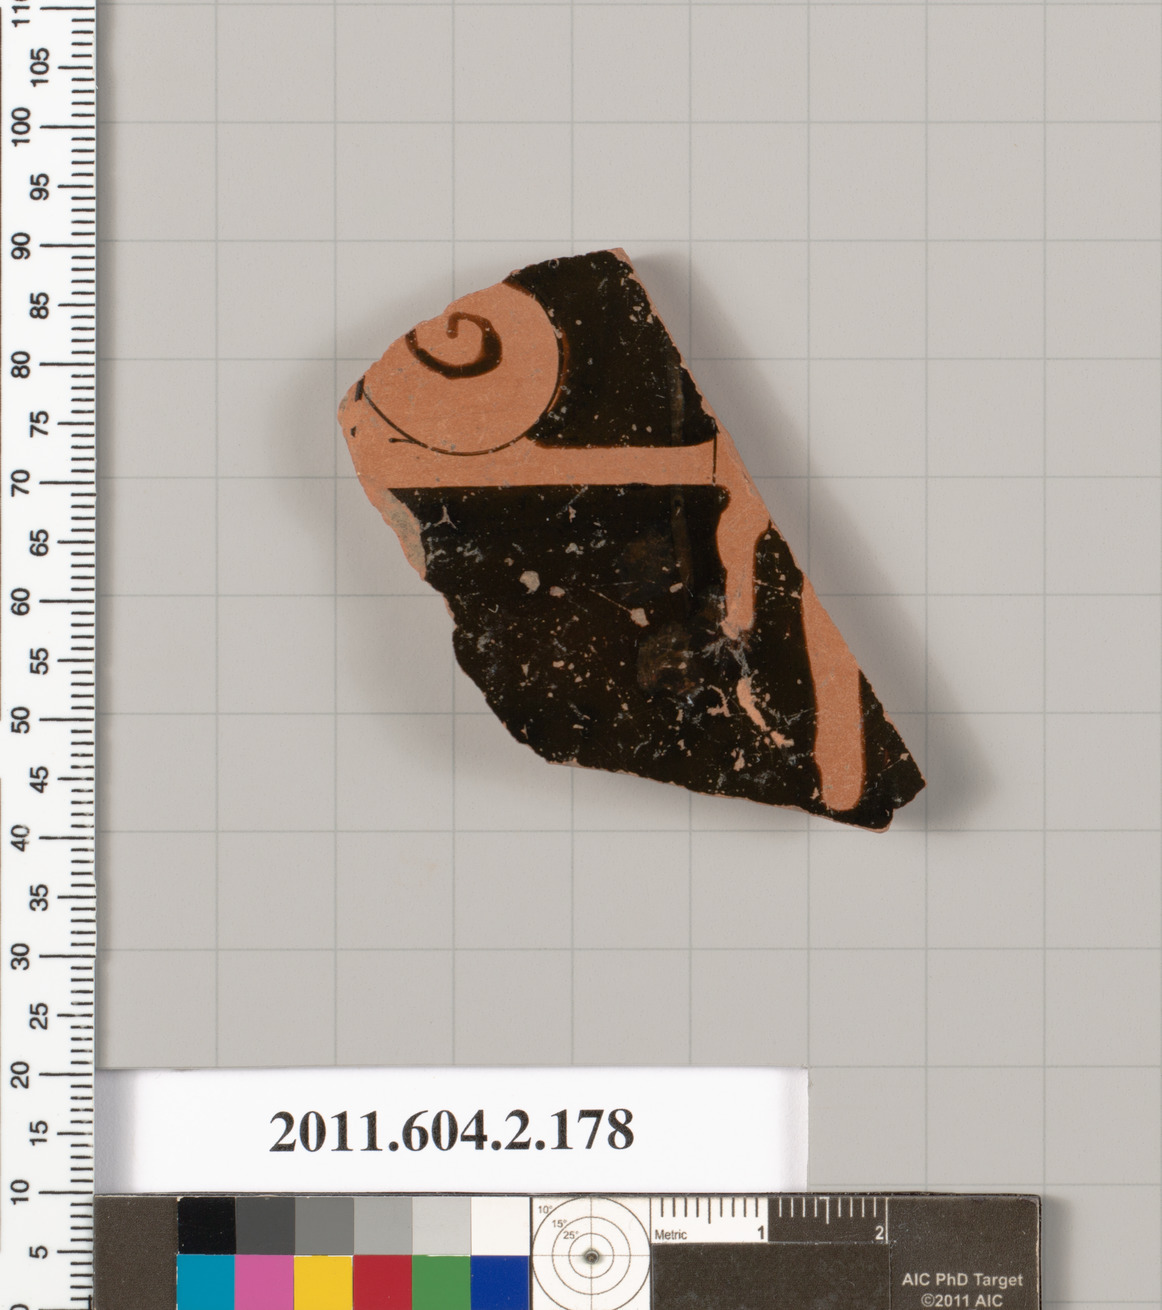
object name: stamnos fragment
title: Terracotta fragment of a stamnos (jar)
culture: greek, attic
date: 450-426 BCE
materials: terracotta